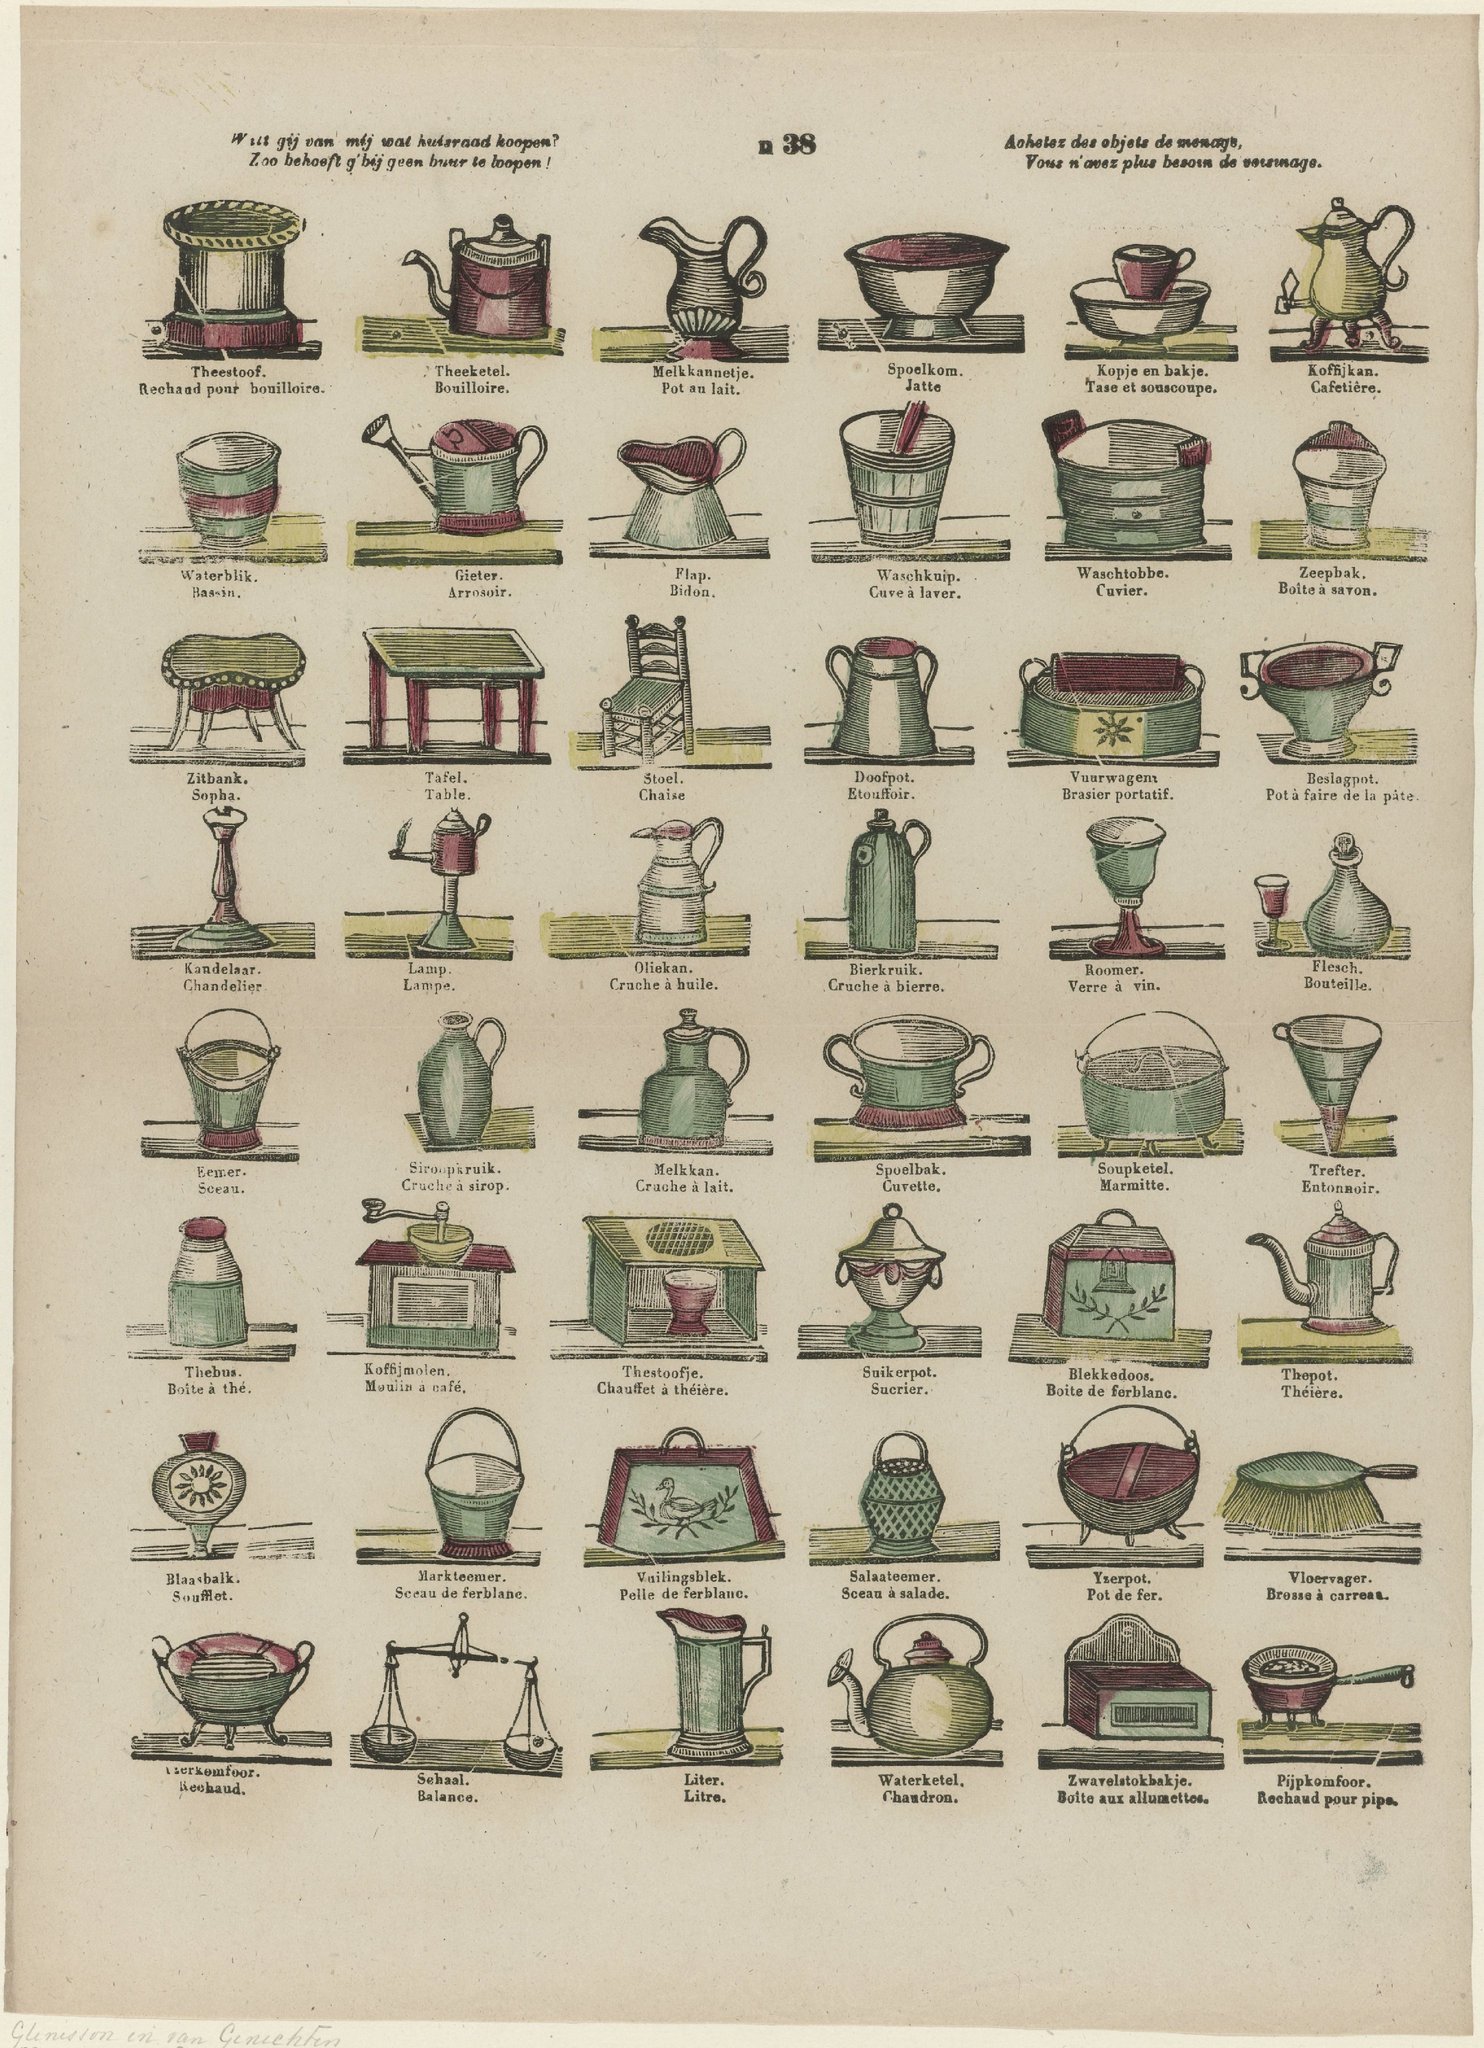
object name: popular print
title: Wilt gij van mij wat huisraad koopen? / Zoo behoeft g'bij geen buur te loopen! / Achetez des objets de menage, / Vous n'avez plus beson de voisinage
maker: Anonymous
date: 1856-1900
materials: paper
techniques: colour, letterpress printing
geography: turnhout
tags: (household) utensils and implements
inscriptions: collector's mark: Lugt 2760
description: Blad met 48 voorstellingen van alledaagse voorwerpen (huisraad), waaronder een theepot, een gieter, een bierkruik, een koffiemolen, een blaasbalg en een weegschaal. Onder elke afbeelding een onderschrift in het Nederlands en in het Frans. Genummerd midden boven: n 38.